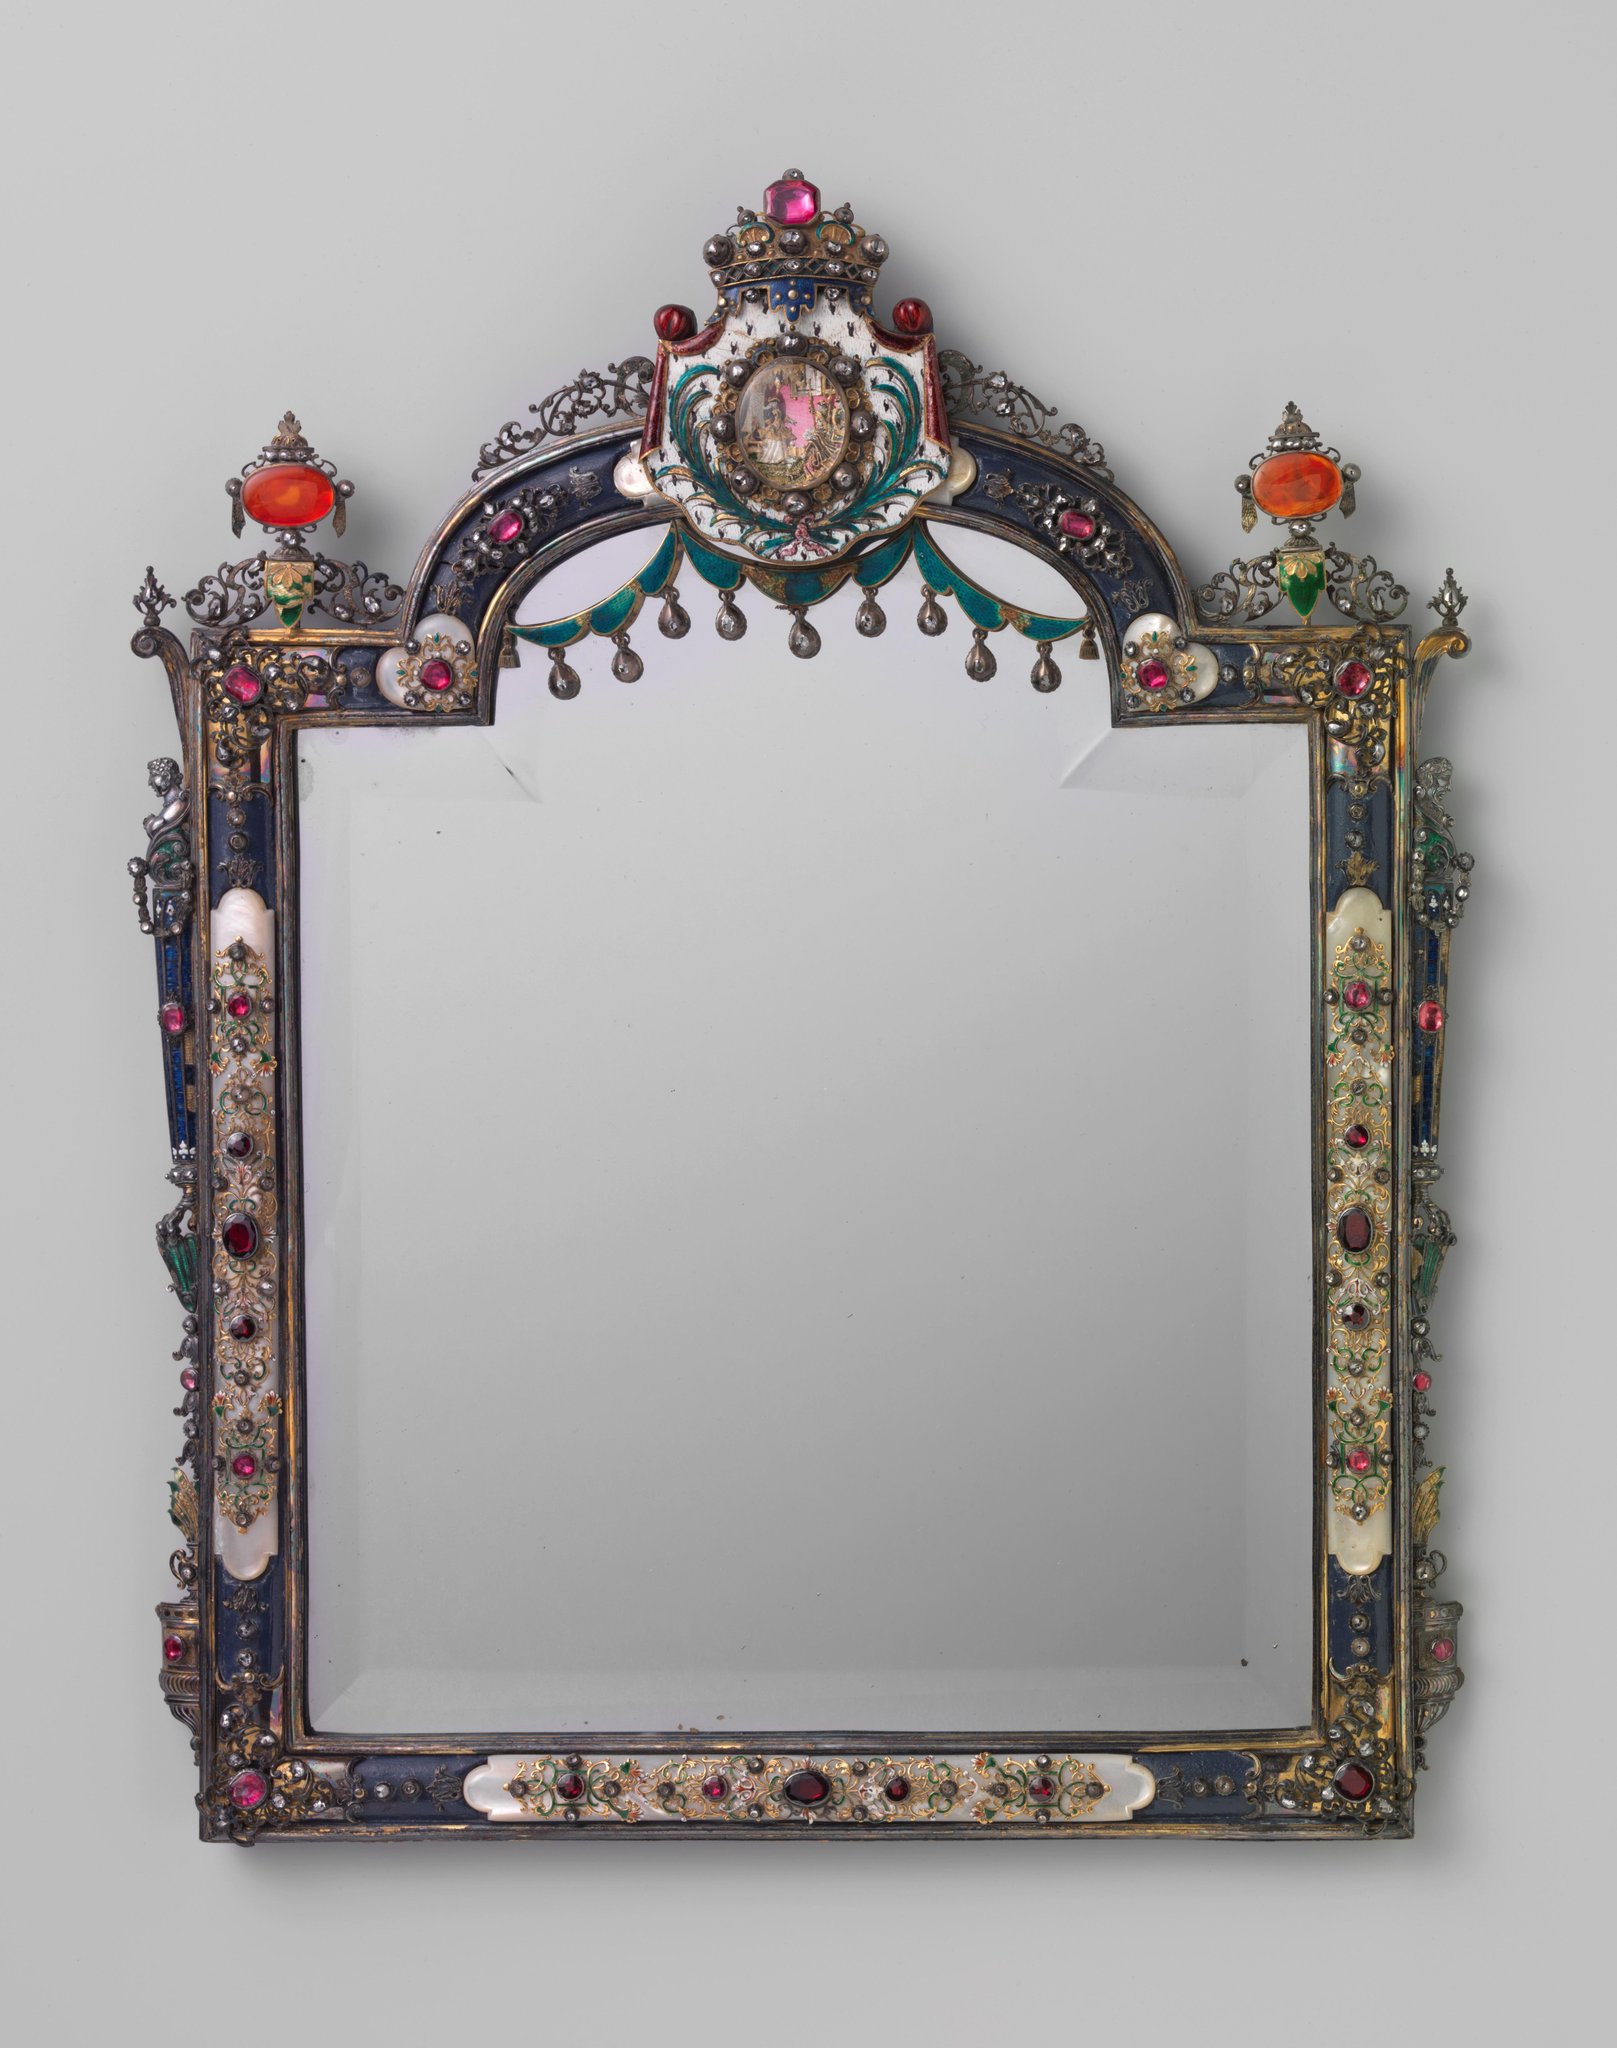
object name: mirror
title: Spiegel, staand model, met geslepen randen en in een opengewerkte lijst van goud en zilver met ornamenten van parelmoer, bezet met granaten en carneool. Op achterzijde geschilderde Chinoiserieën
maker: Anonymous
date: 1700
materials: amalgam, gemstone, glass, gold, mother of pearl, silver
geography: dresden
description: Mirror. Gold, enamel, mother-of-pearl, precious stones and lacquer. Dresden, c. 1700.